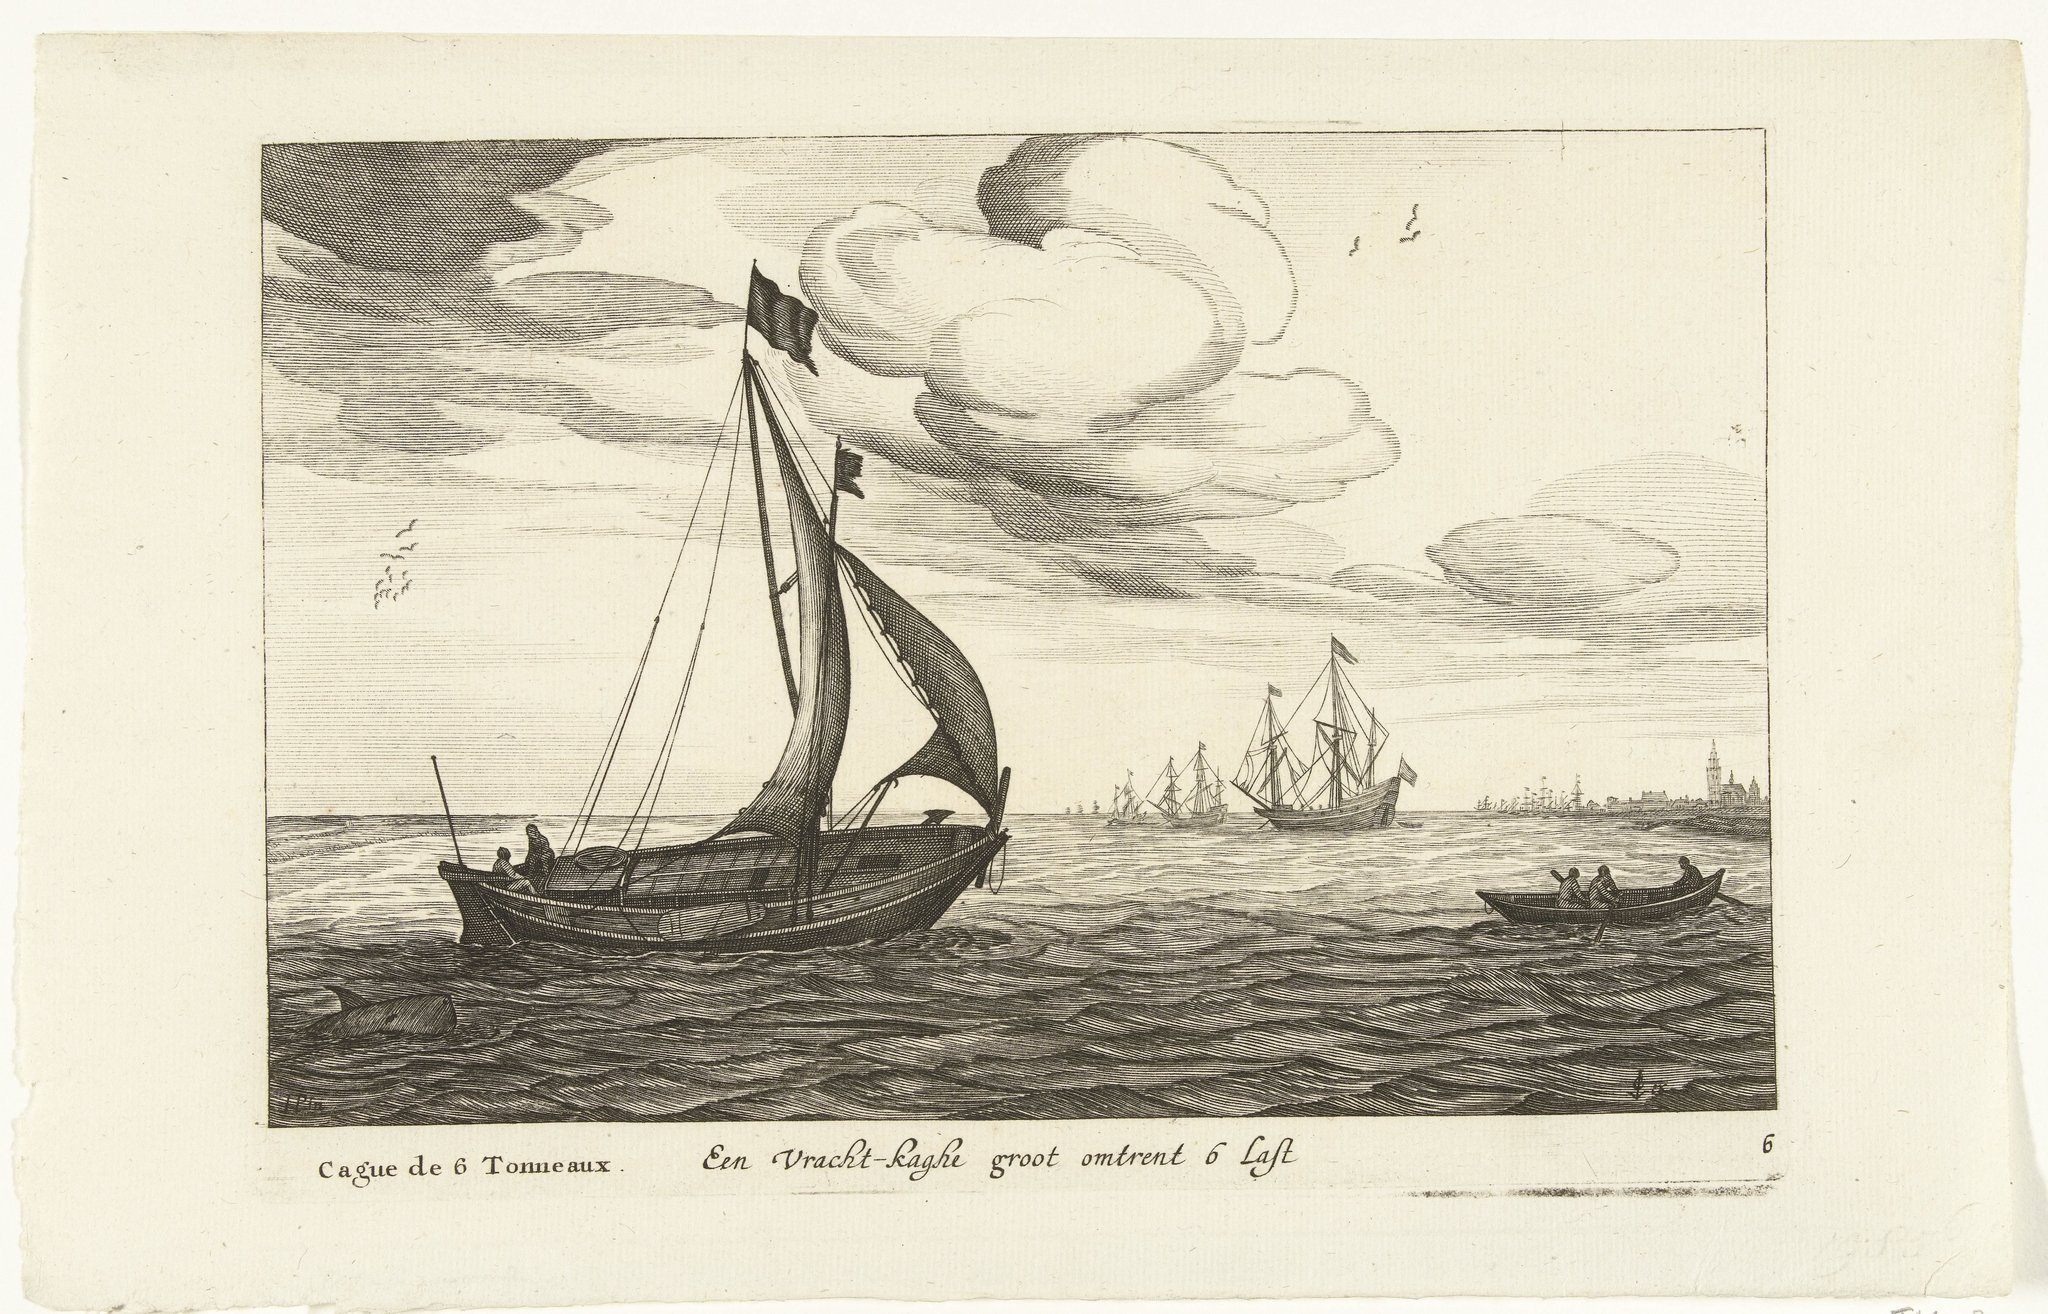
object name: print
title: Vrachtkagen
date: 1627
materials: paper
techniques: engraving, etching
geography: northern netherlands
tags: sailing-ship, sailing-boat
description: Vrachtkagen op het water. Prent nr. 6 in een serie prenten van Hollandse scheepstypen, 1627. .